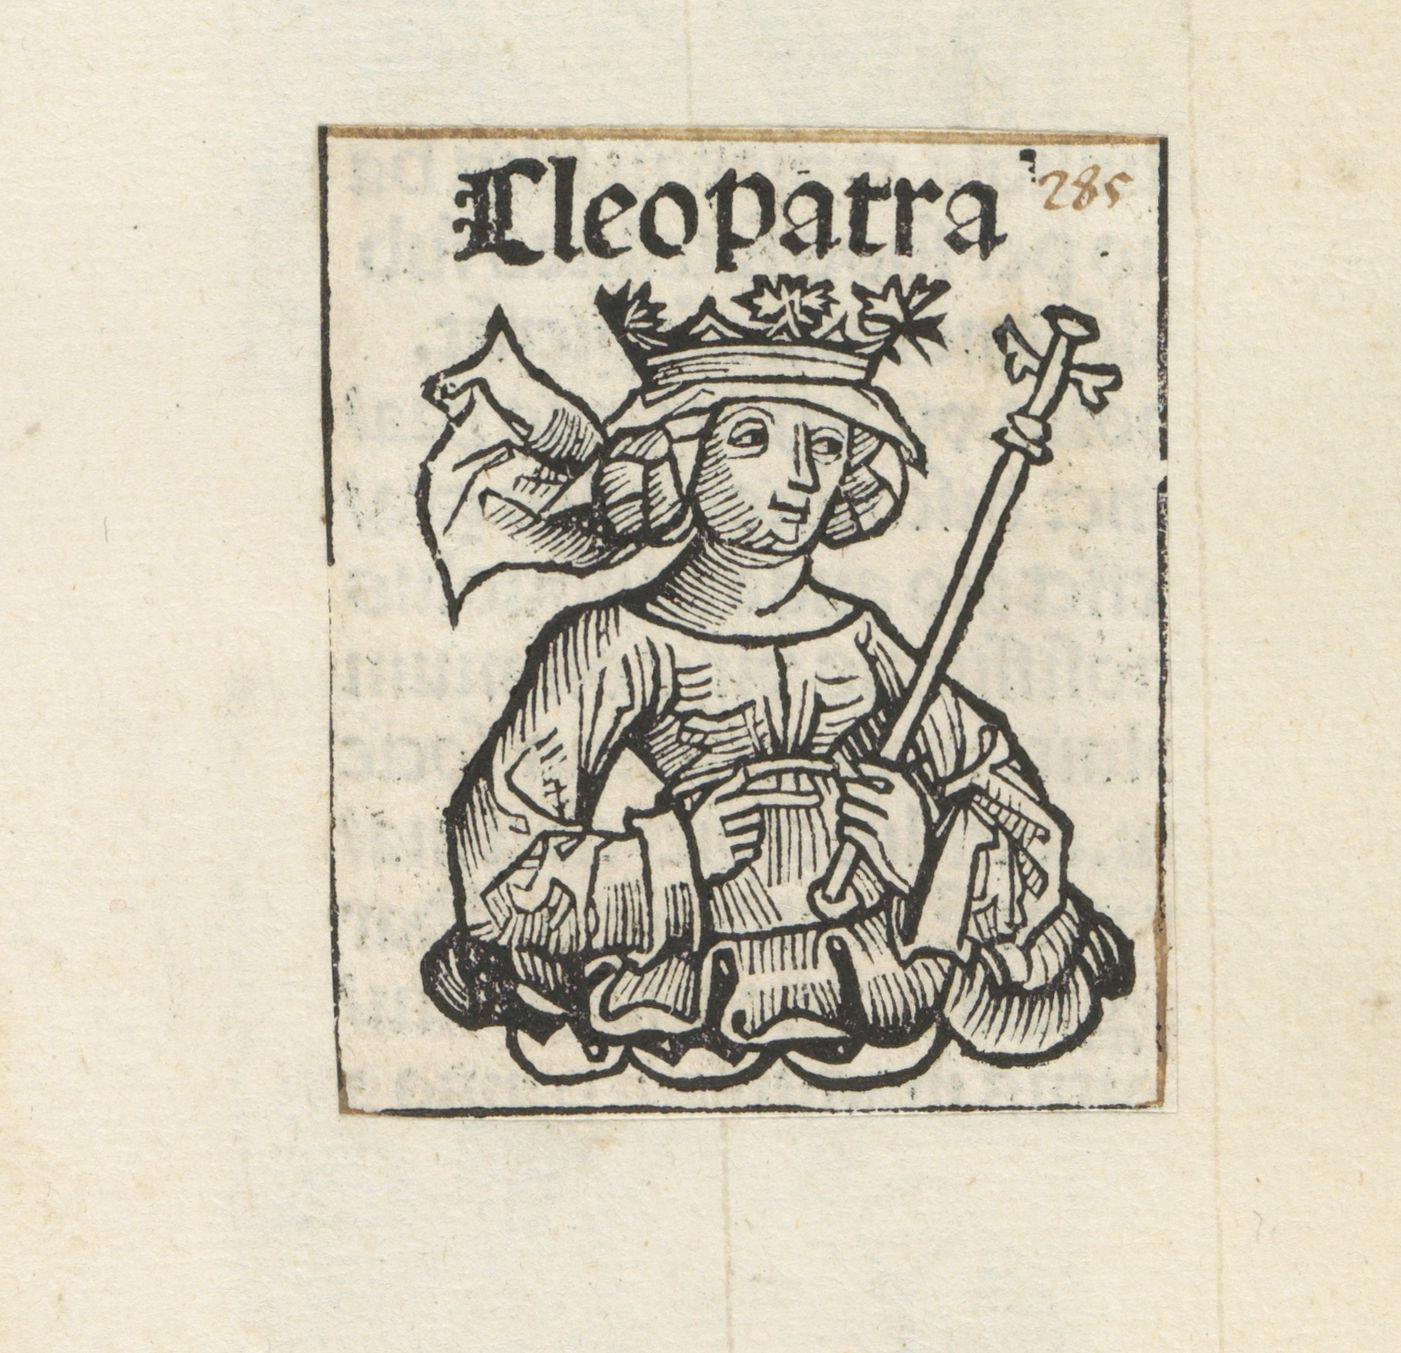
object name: book illustration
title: Koningin Cleopatra VII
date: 1493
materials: paper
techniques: letterpress printing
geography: nuremberg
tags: queen, empress, etc. (wife of a ruler)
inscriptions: inscription: ‘285’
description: Een bloemkelk waarin een koningin met scepter, naar rechts gekeerd. De voorstelling is een onderdeel van de opeenvolging Egyptische farao's in de Liber Chronicarum. De tekst identificeert haar als de Egyptische koningin Cleopatra, dochter van Ptolemaeus XII Neos Dionysos. De prent maakt deel uit van een album.